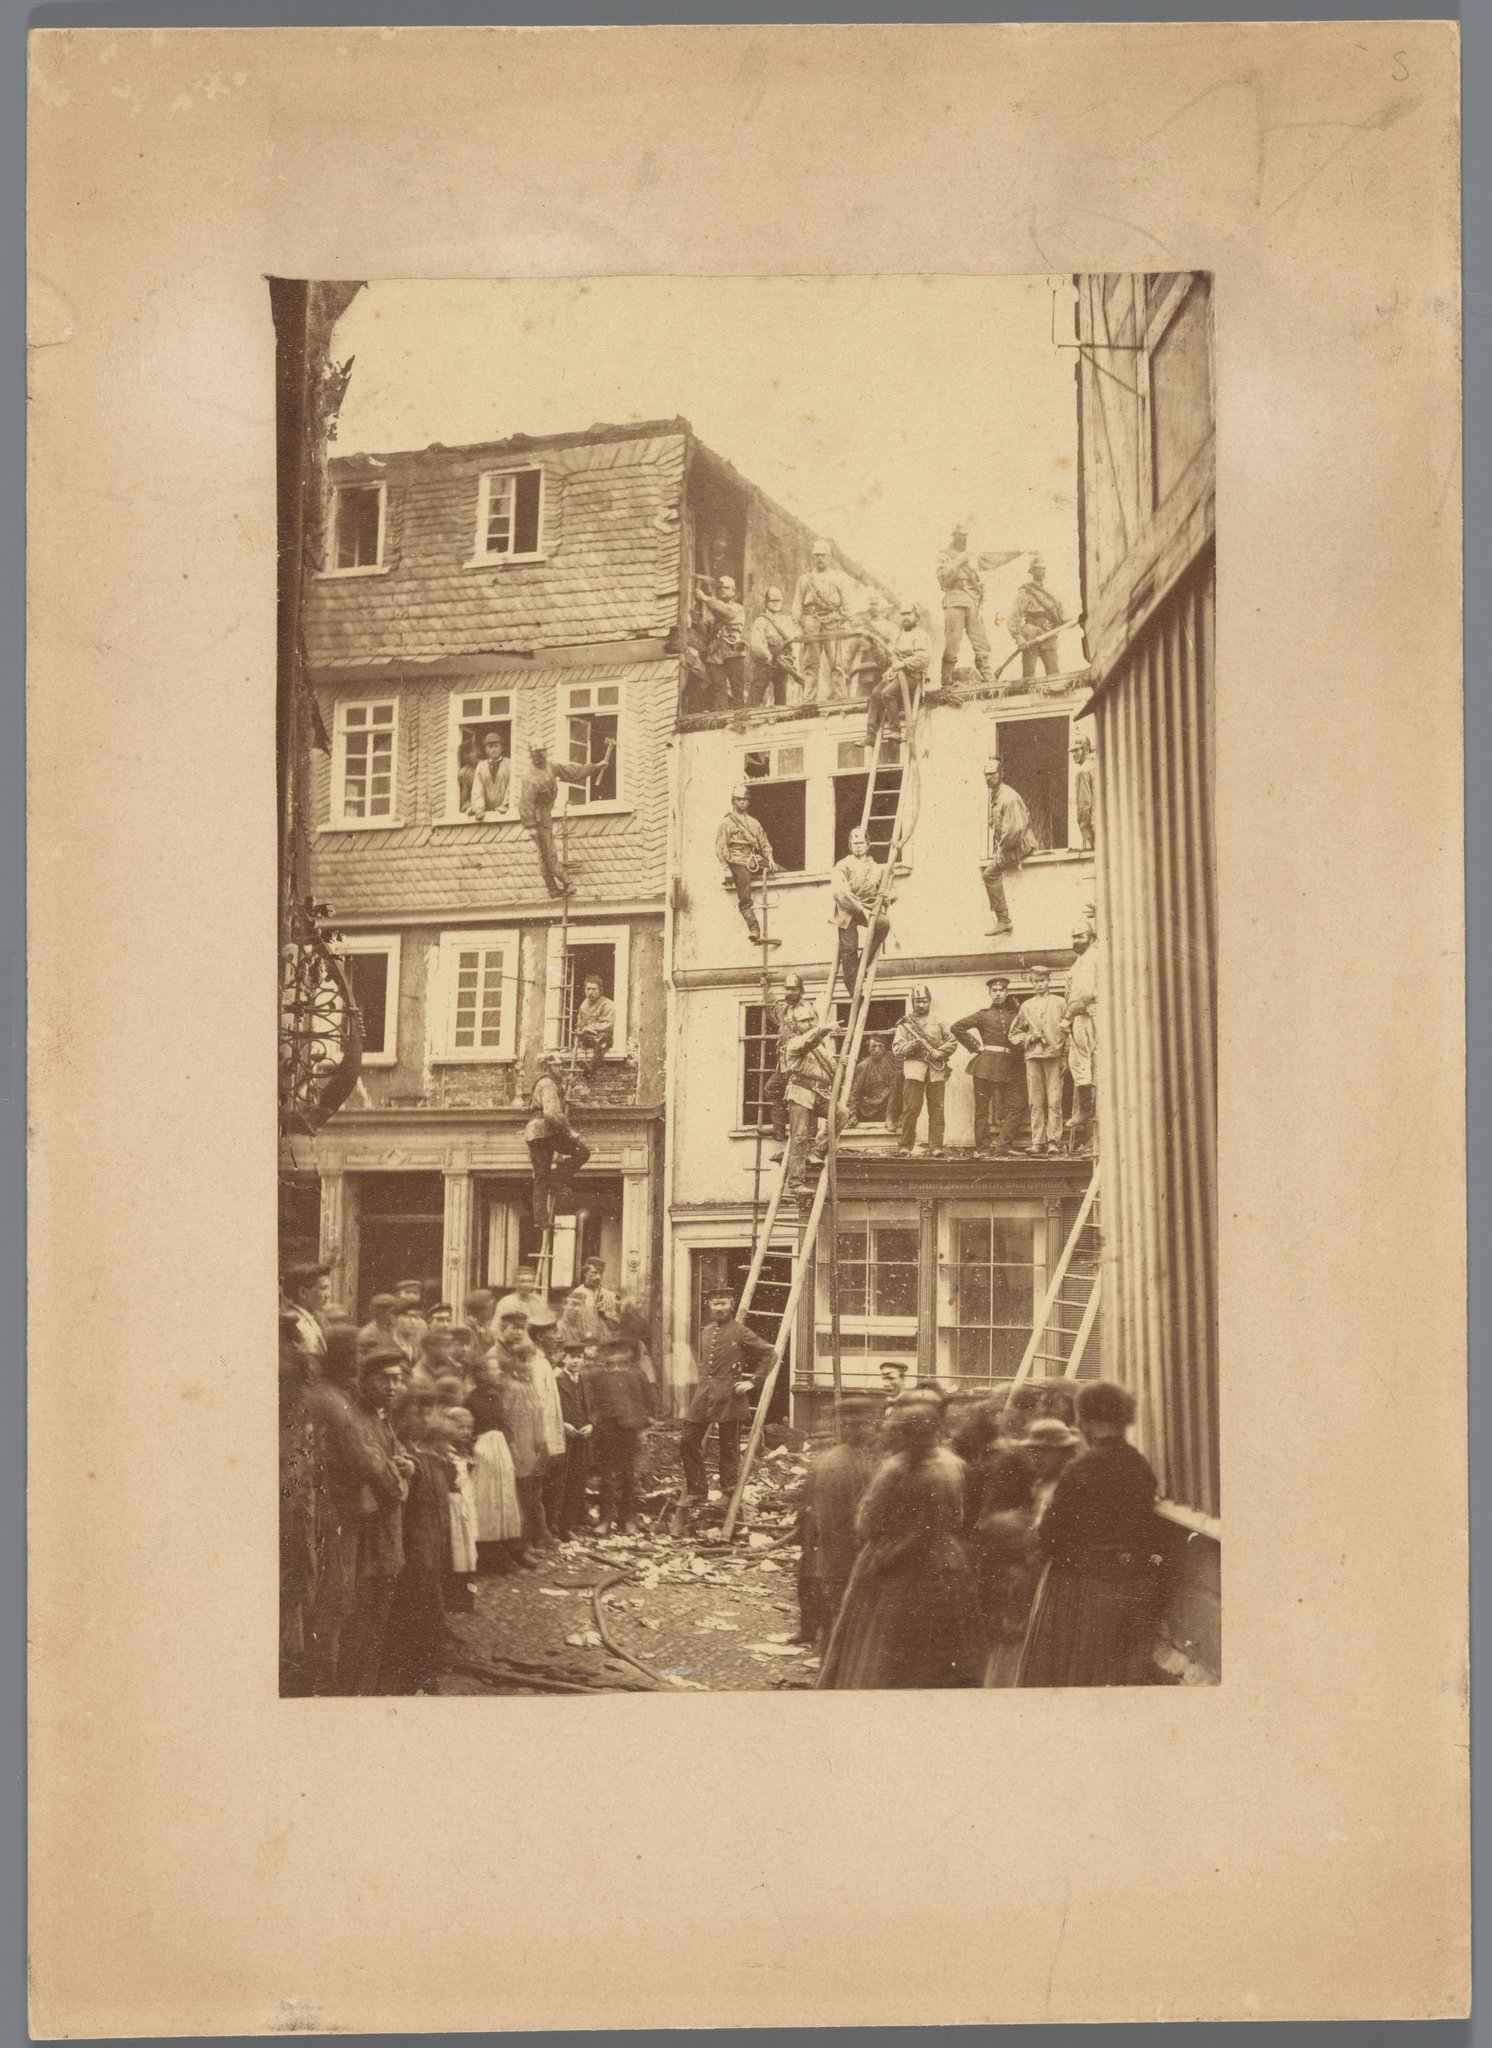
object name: photograph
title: Brandweerlieden en publiek bij een net uitgebrand gebouw, waarschijnlijk Duitsland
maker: Anonymous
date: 1870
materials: cardboard, paper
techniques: albumen print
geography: germany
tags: firemen, germany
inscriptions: inscription: ‘[...] großer Brand in der/ Kä[...]strasse 7.6.1870/ mit der [...]’